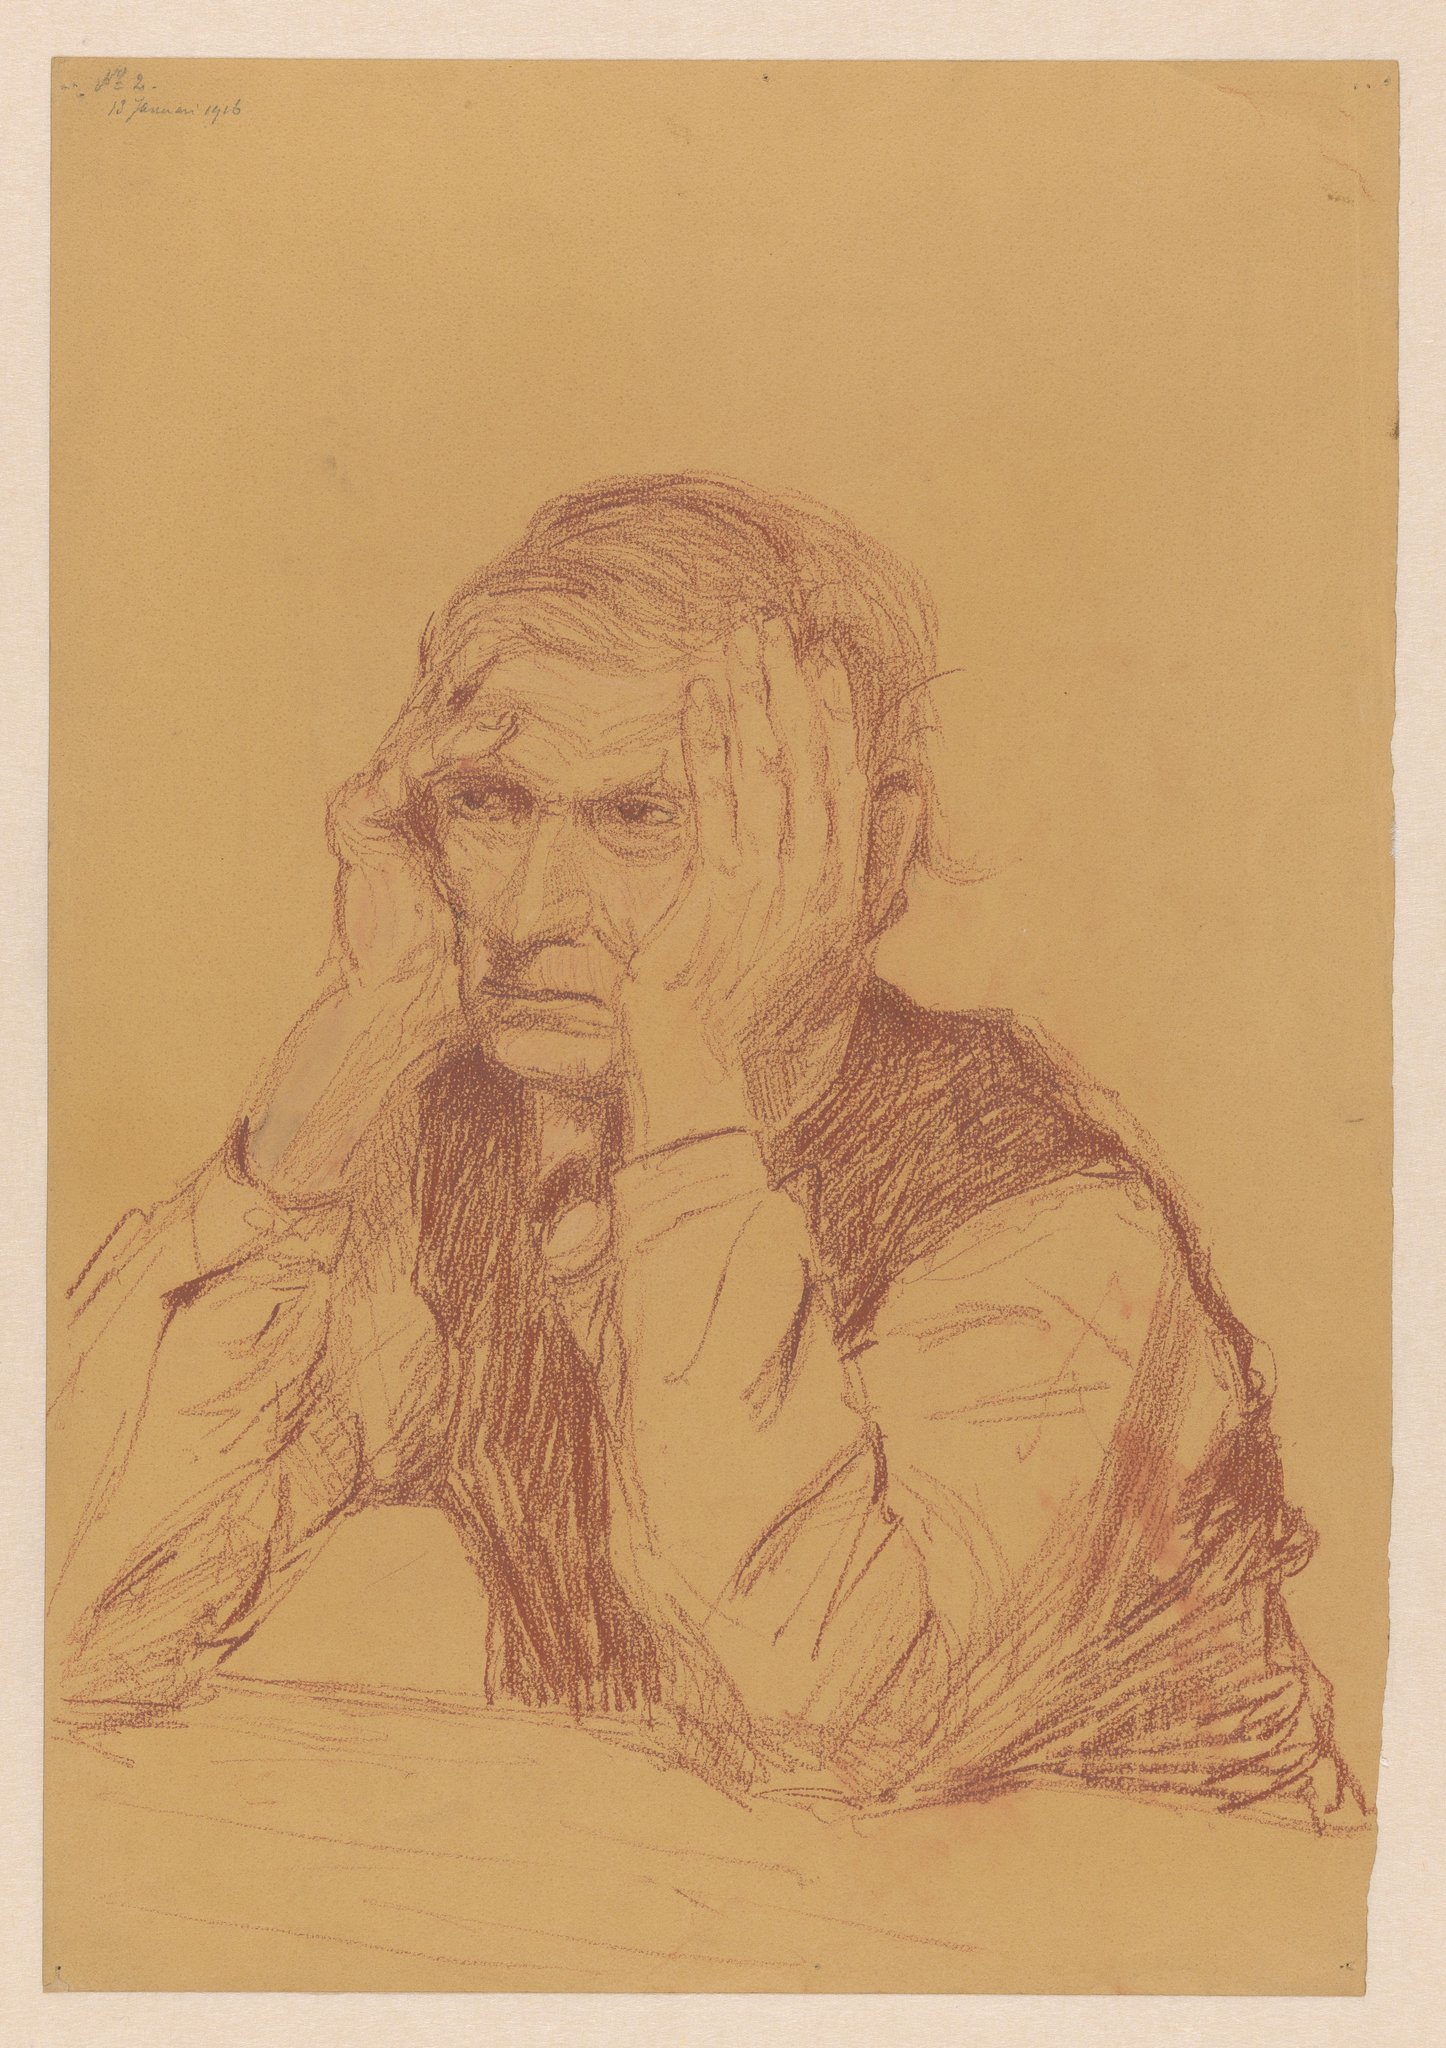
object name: drawing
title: Zittende man met het hoofd in de handen gesteund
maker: jan paul valkema blouw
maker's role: draughtsman, print maker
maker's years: 1884-1954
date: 1916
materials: chalk, paper, pencil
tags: sitting figure, anonymous historical person portrayed alone